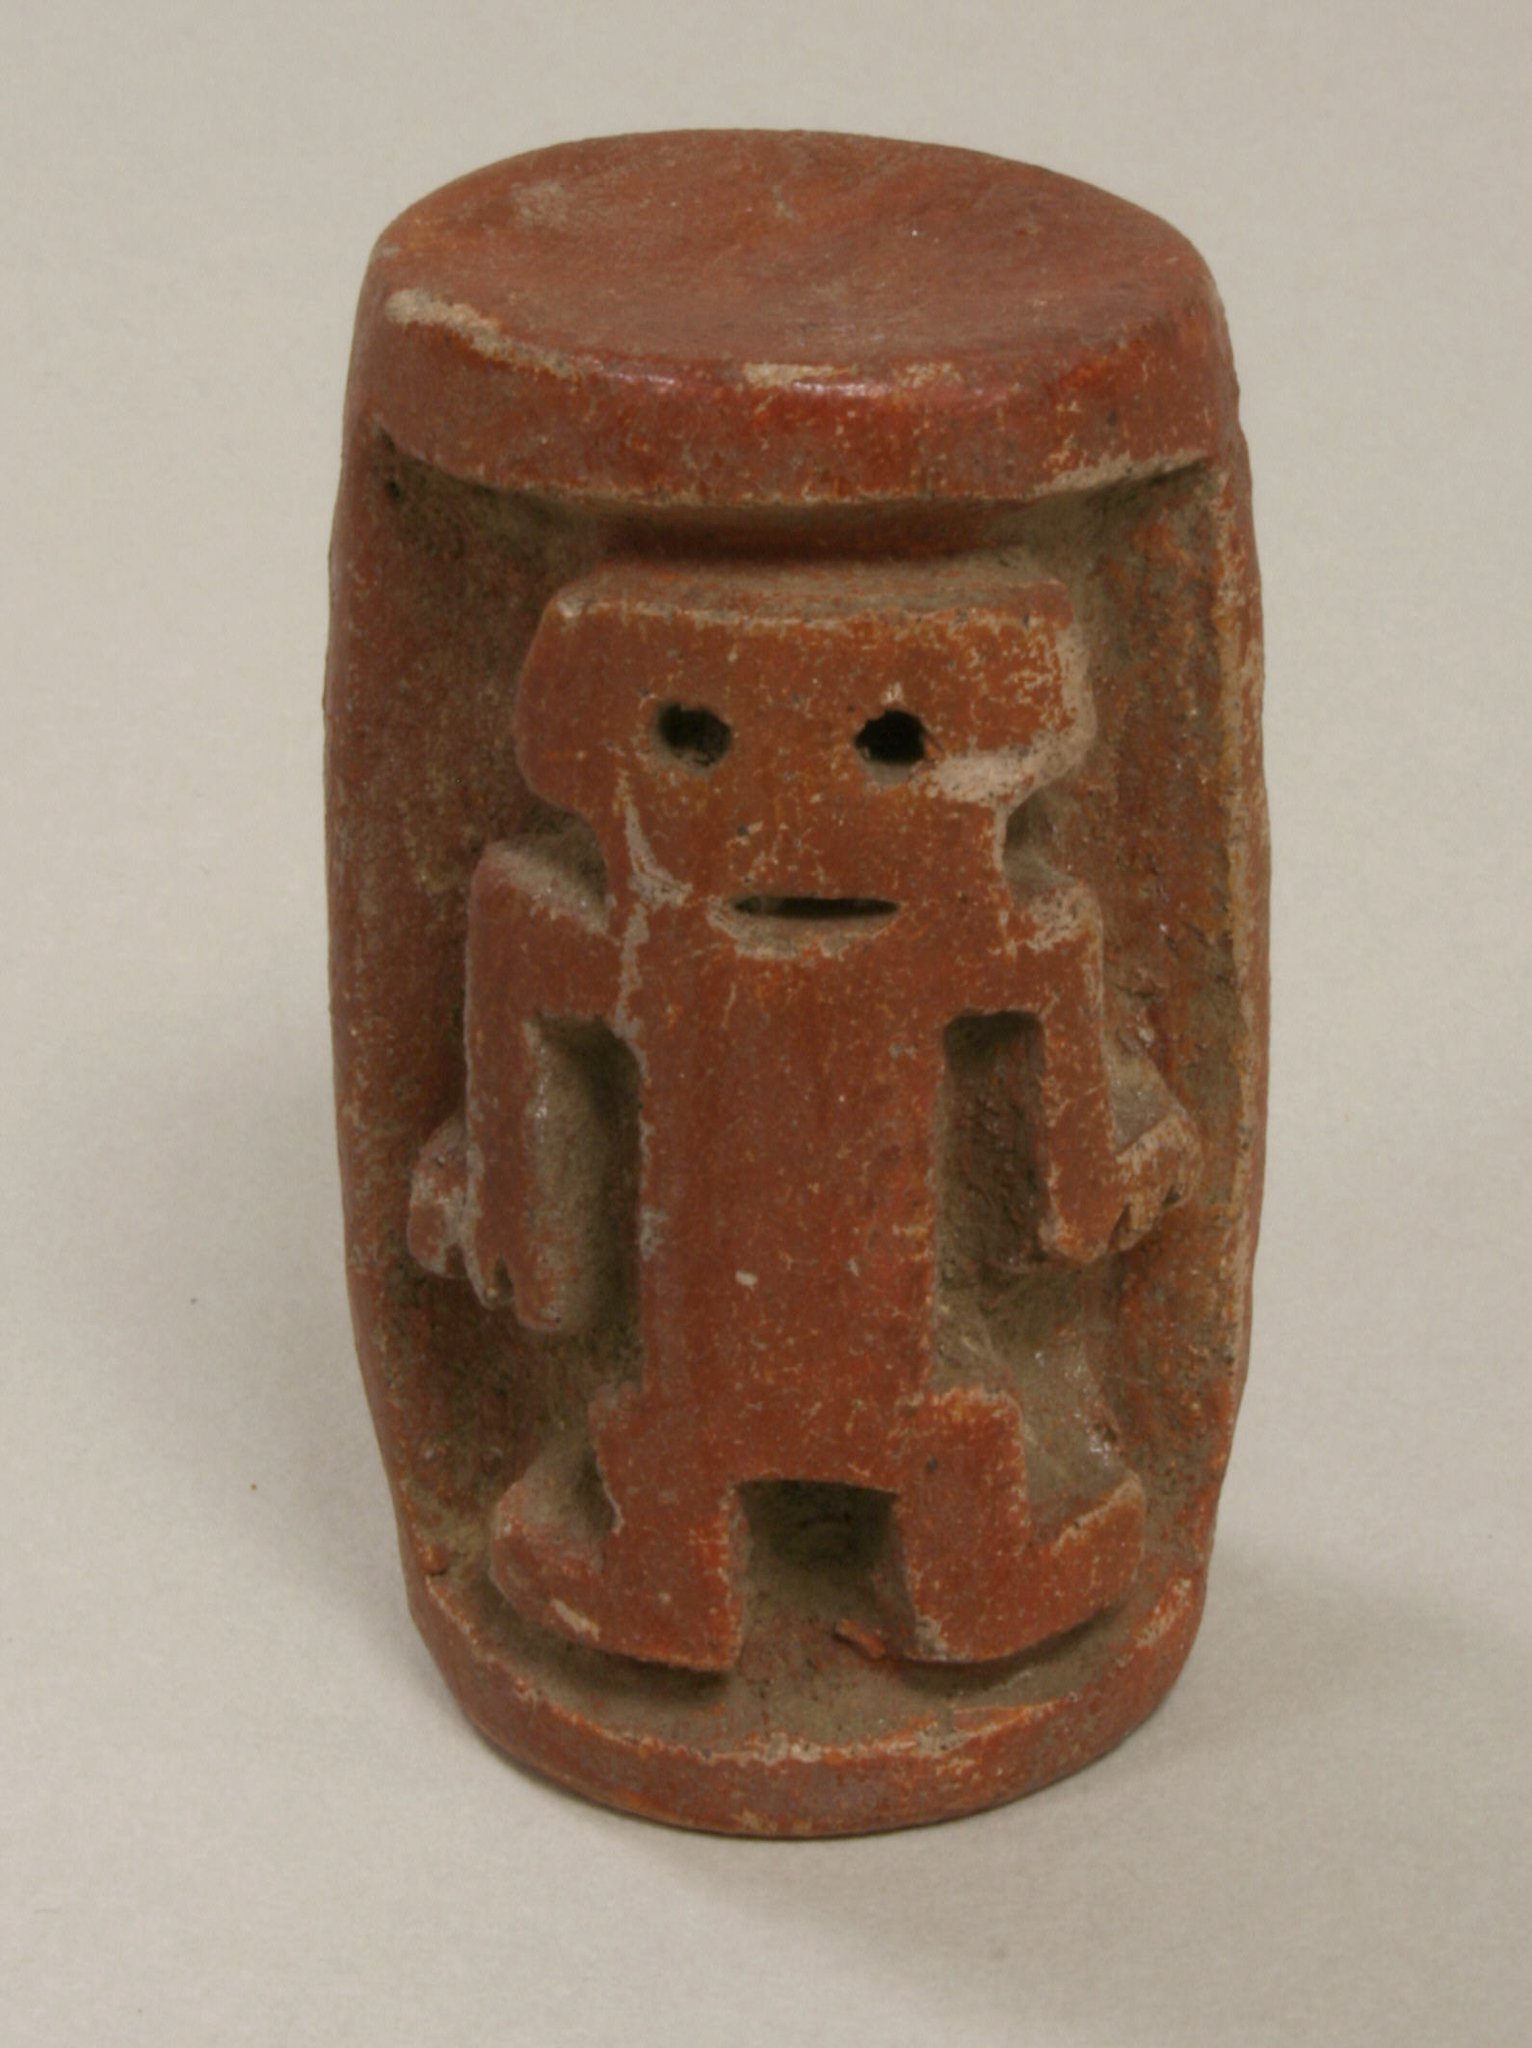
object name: stamp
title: Roller Stamp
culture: atlantic watershed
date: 401-600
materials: ceramic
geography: costa rica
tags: human figures